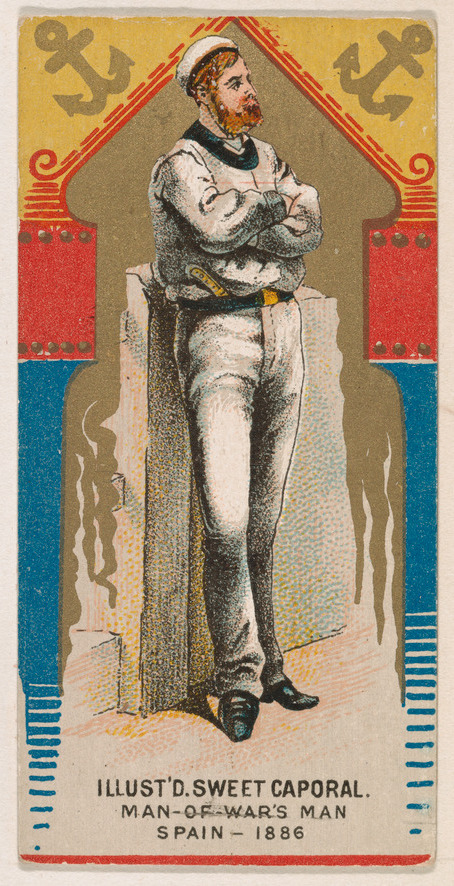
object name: print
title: Man-of-War's Man, Spain, 1886, from the Military Series (N224) issued by Kinney Tobacco Company to promote Sweet Caporal Cigarettes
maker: kinney brothers tobacco company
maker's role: publisher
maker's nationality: american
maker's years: 1869-2011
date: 1888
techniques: color lithograph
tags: men,profiles